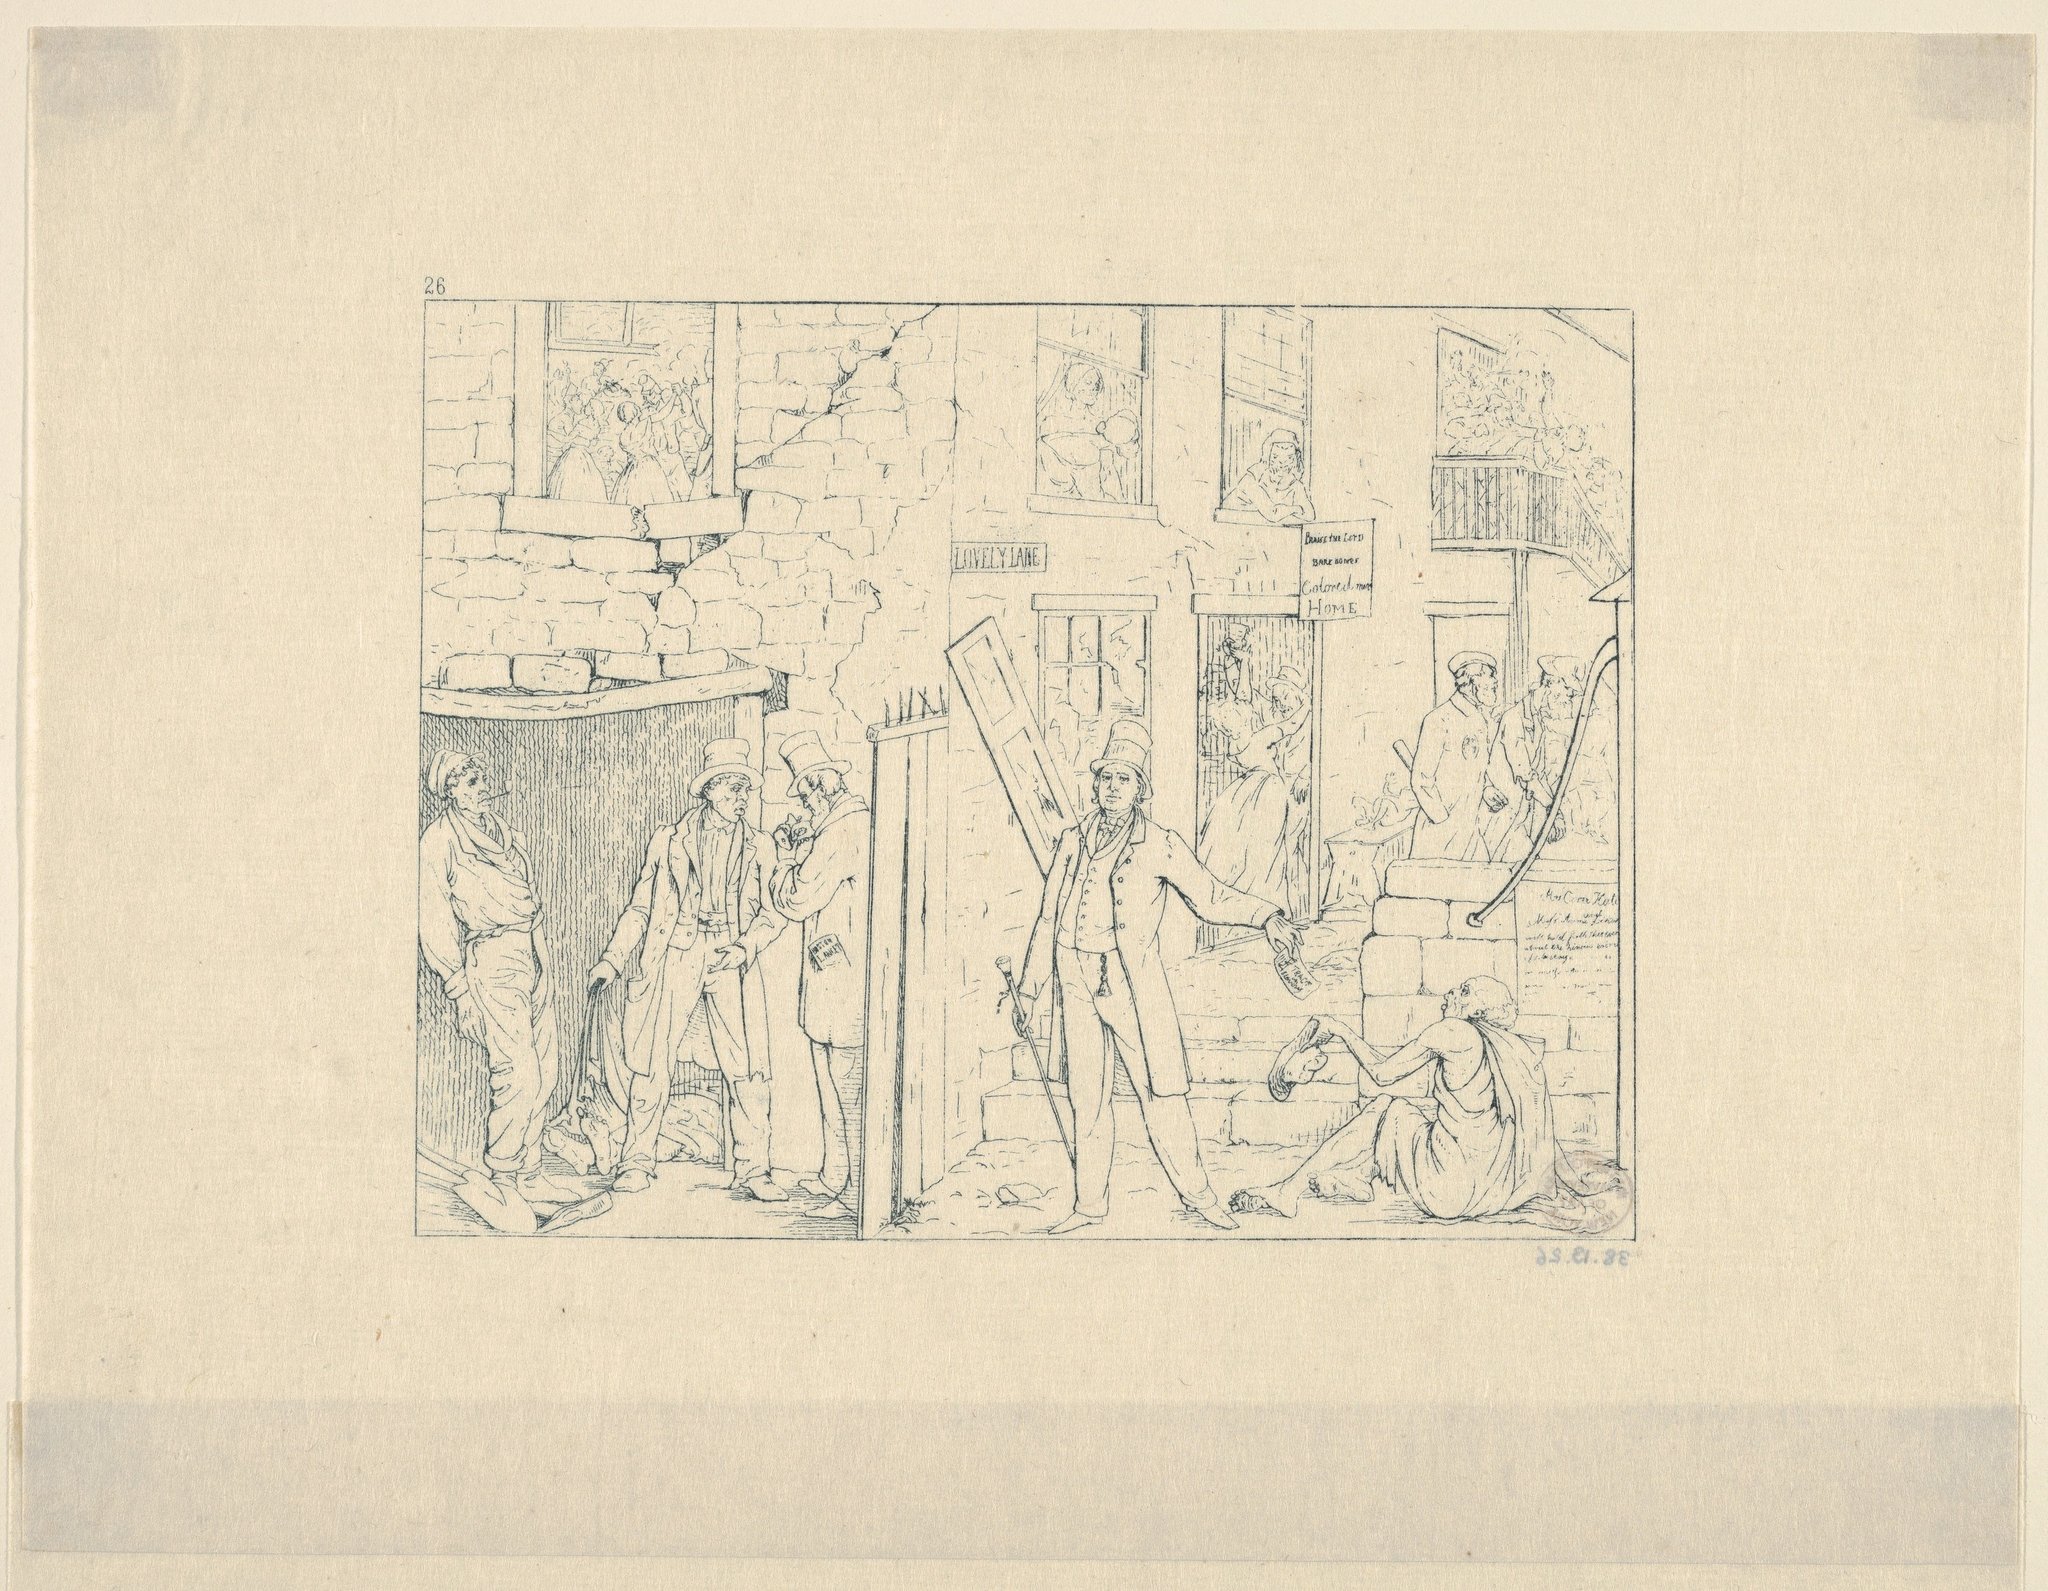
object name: print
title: Free Negroes in the North (from Confederate War Etchings)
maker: adalbert john volck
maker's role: artist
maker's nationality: american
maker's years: 1828-1912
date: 1861-1863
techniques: etching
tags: american civil war,men